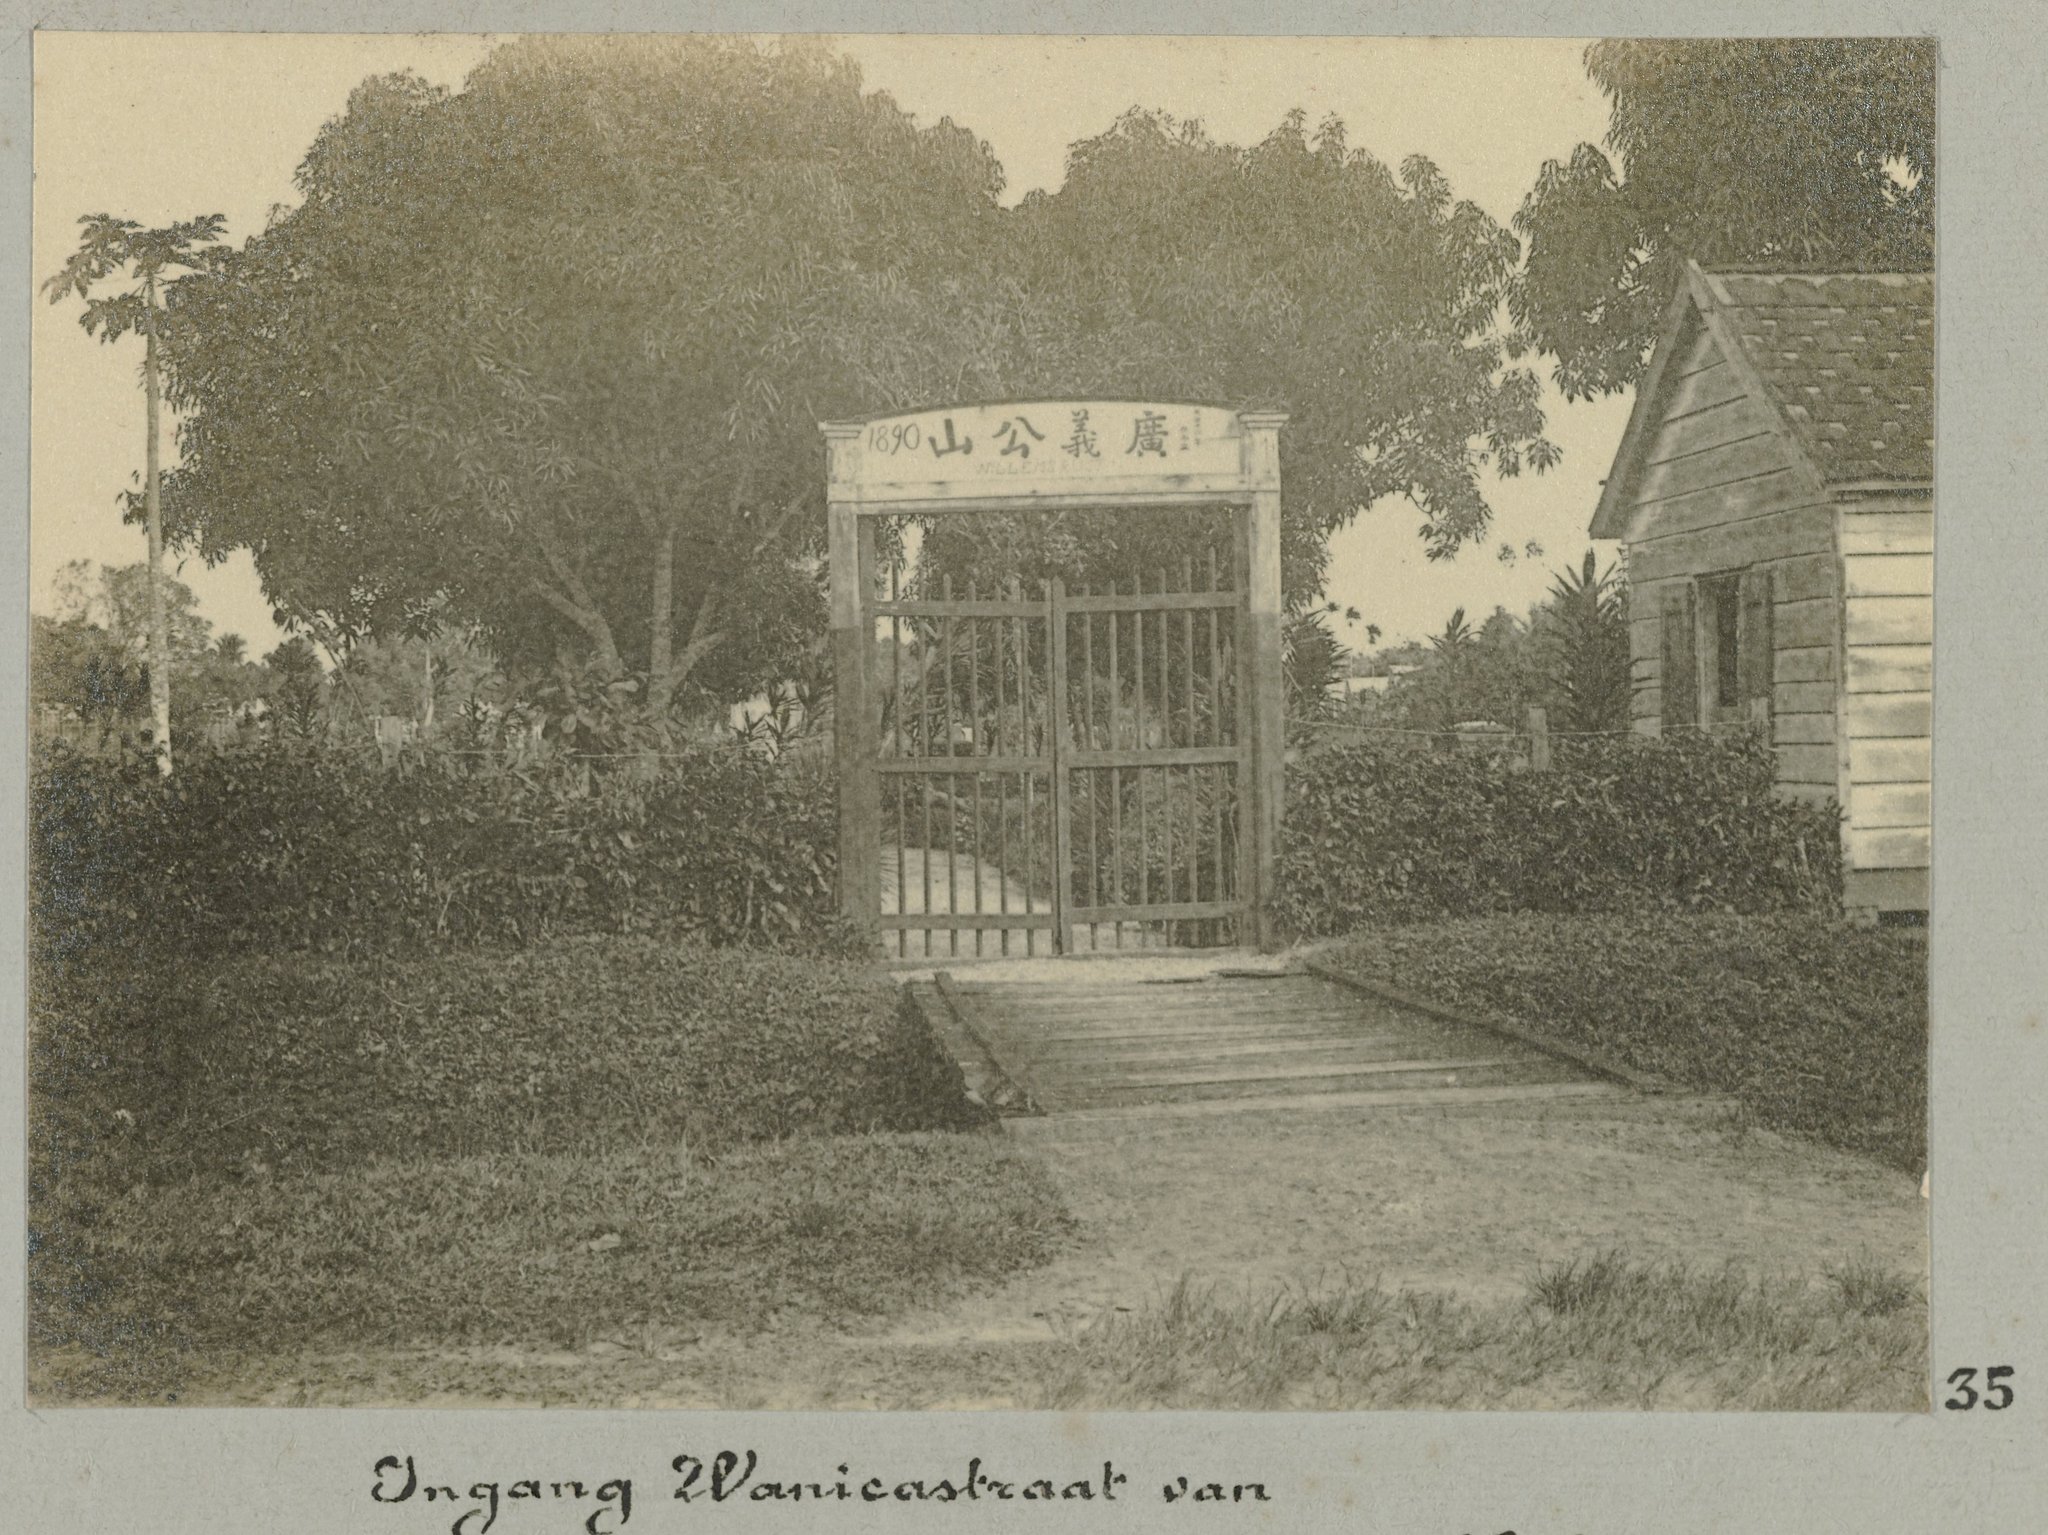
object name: photograph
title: Ingang Wanicastraat van Chineesch kerkhof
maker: hendrik doijer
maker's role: engineer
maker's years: 1863-1925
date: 1903-1910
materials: photographic support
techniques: gelatin silver print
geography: suriname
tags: suriname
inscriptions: inscription: ‘35 / Ingang Wanicastraat van Chineesch kerkhof.’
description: Toegangshek naar het Chinese kerkhof aan de Wanicastraat te Paramaribo, boven het hek een bord met Chinese tekens, het jaartal 1890 en de naam Willemsrust of Willems Rust. Onderdeel van het fotoalbum Souvenir de Voyage (deel 2), over het leven van de familie Doijer in en rond de plantage Ma Retraite in Suriname in de jaren 1903-1910.